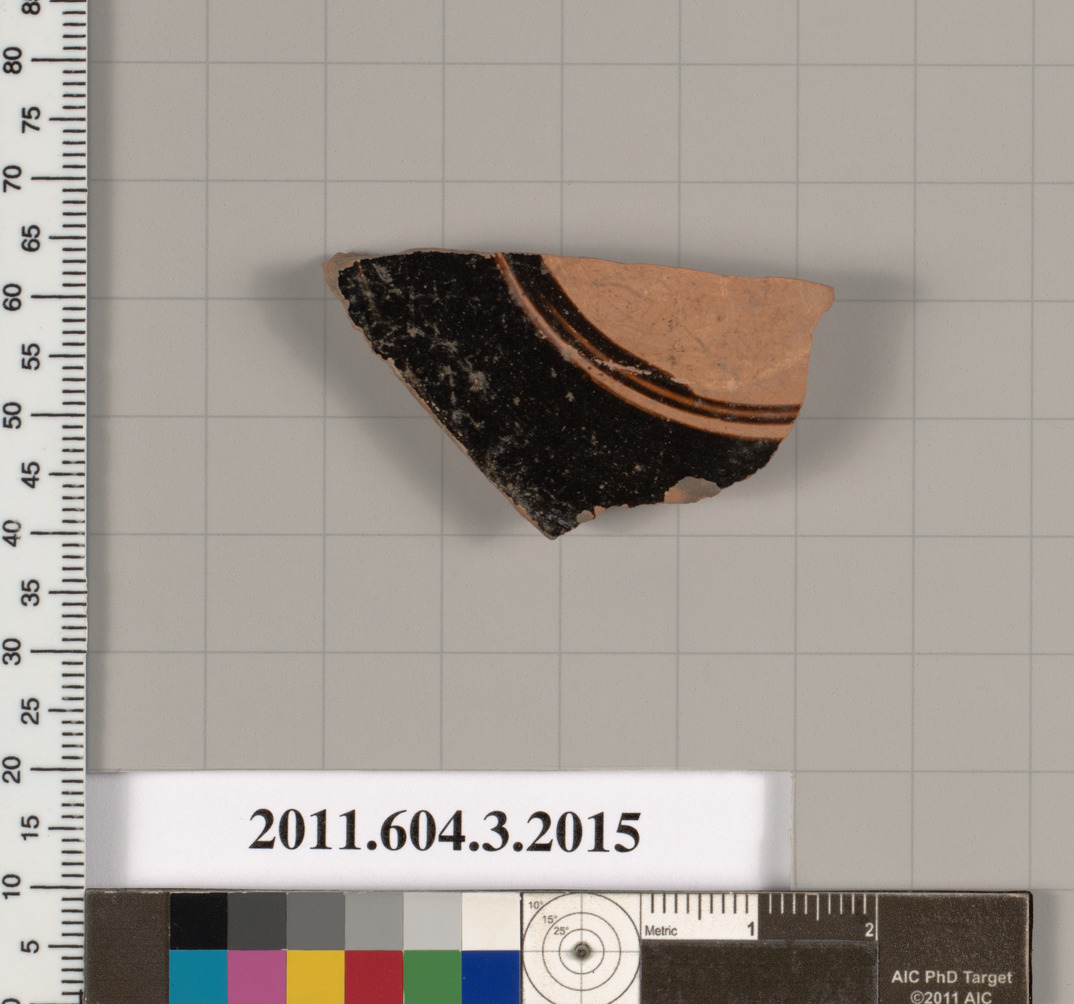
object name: kylix fragment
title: Terracotta fragment of a kylix (drinking cup)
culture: greek, attic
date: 550-526 BCE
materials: terracotta